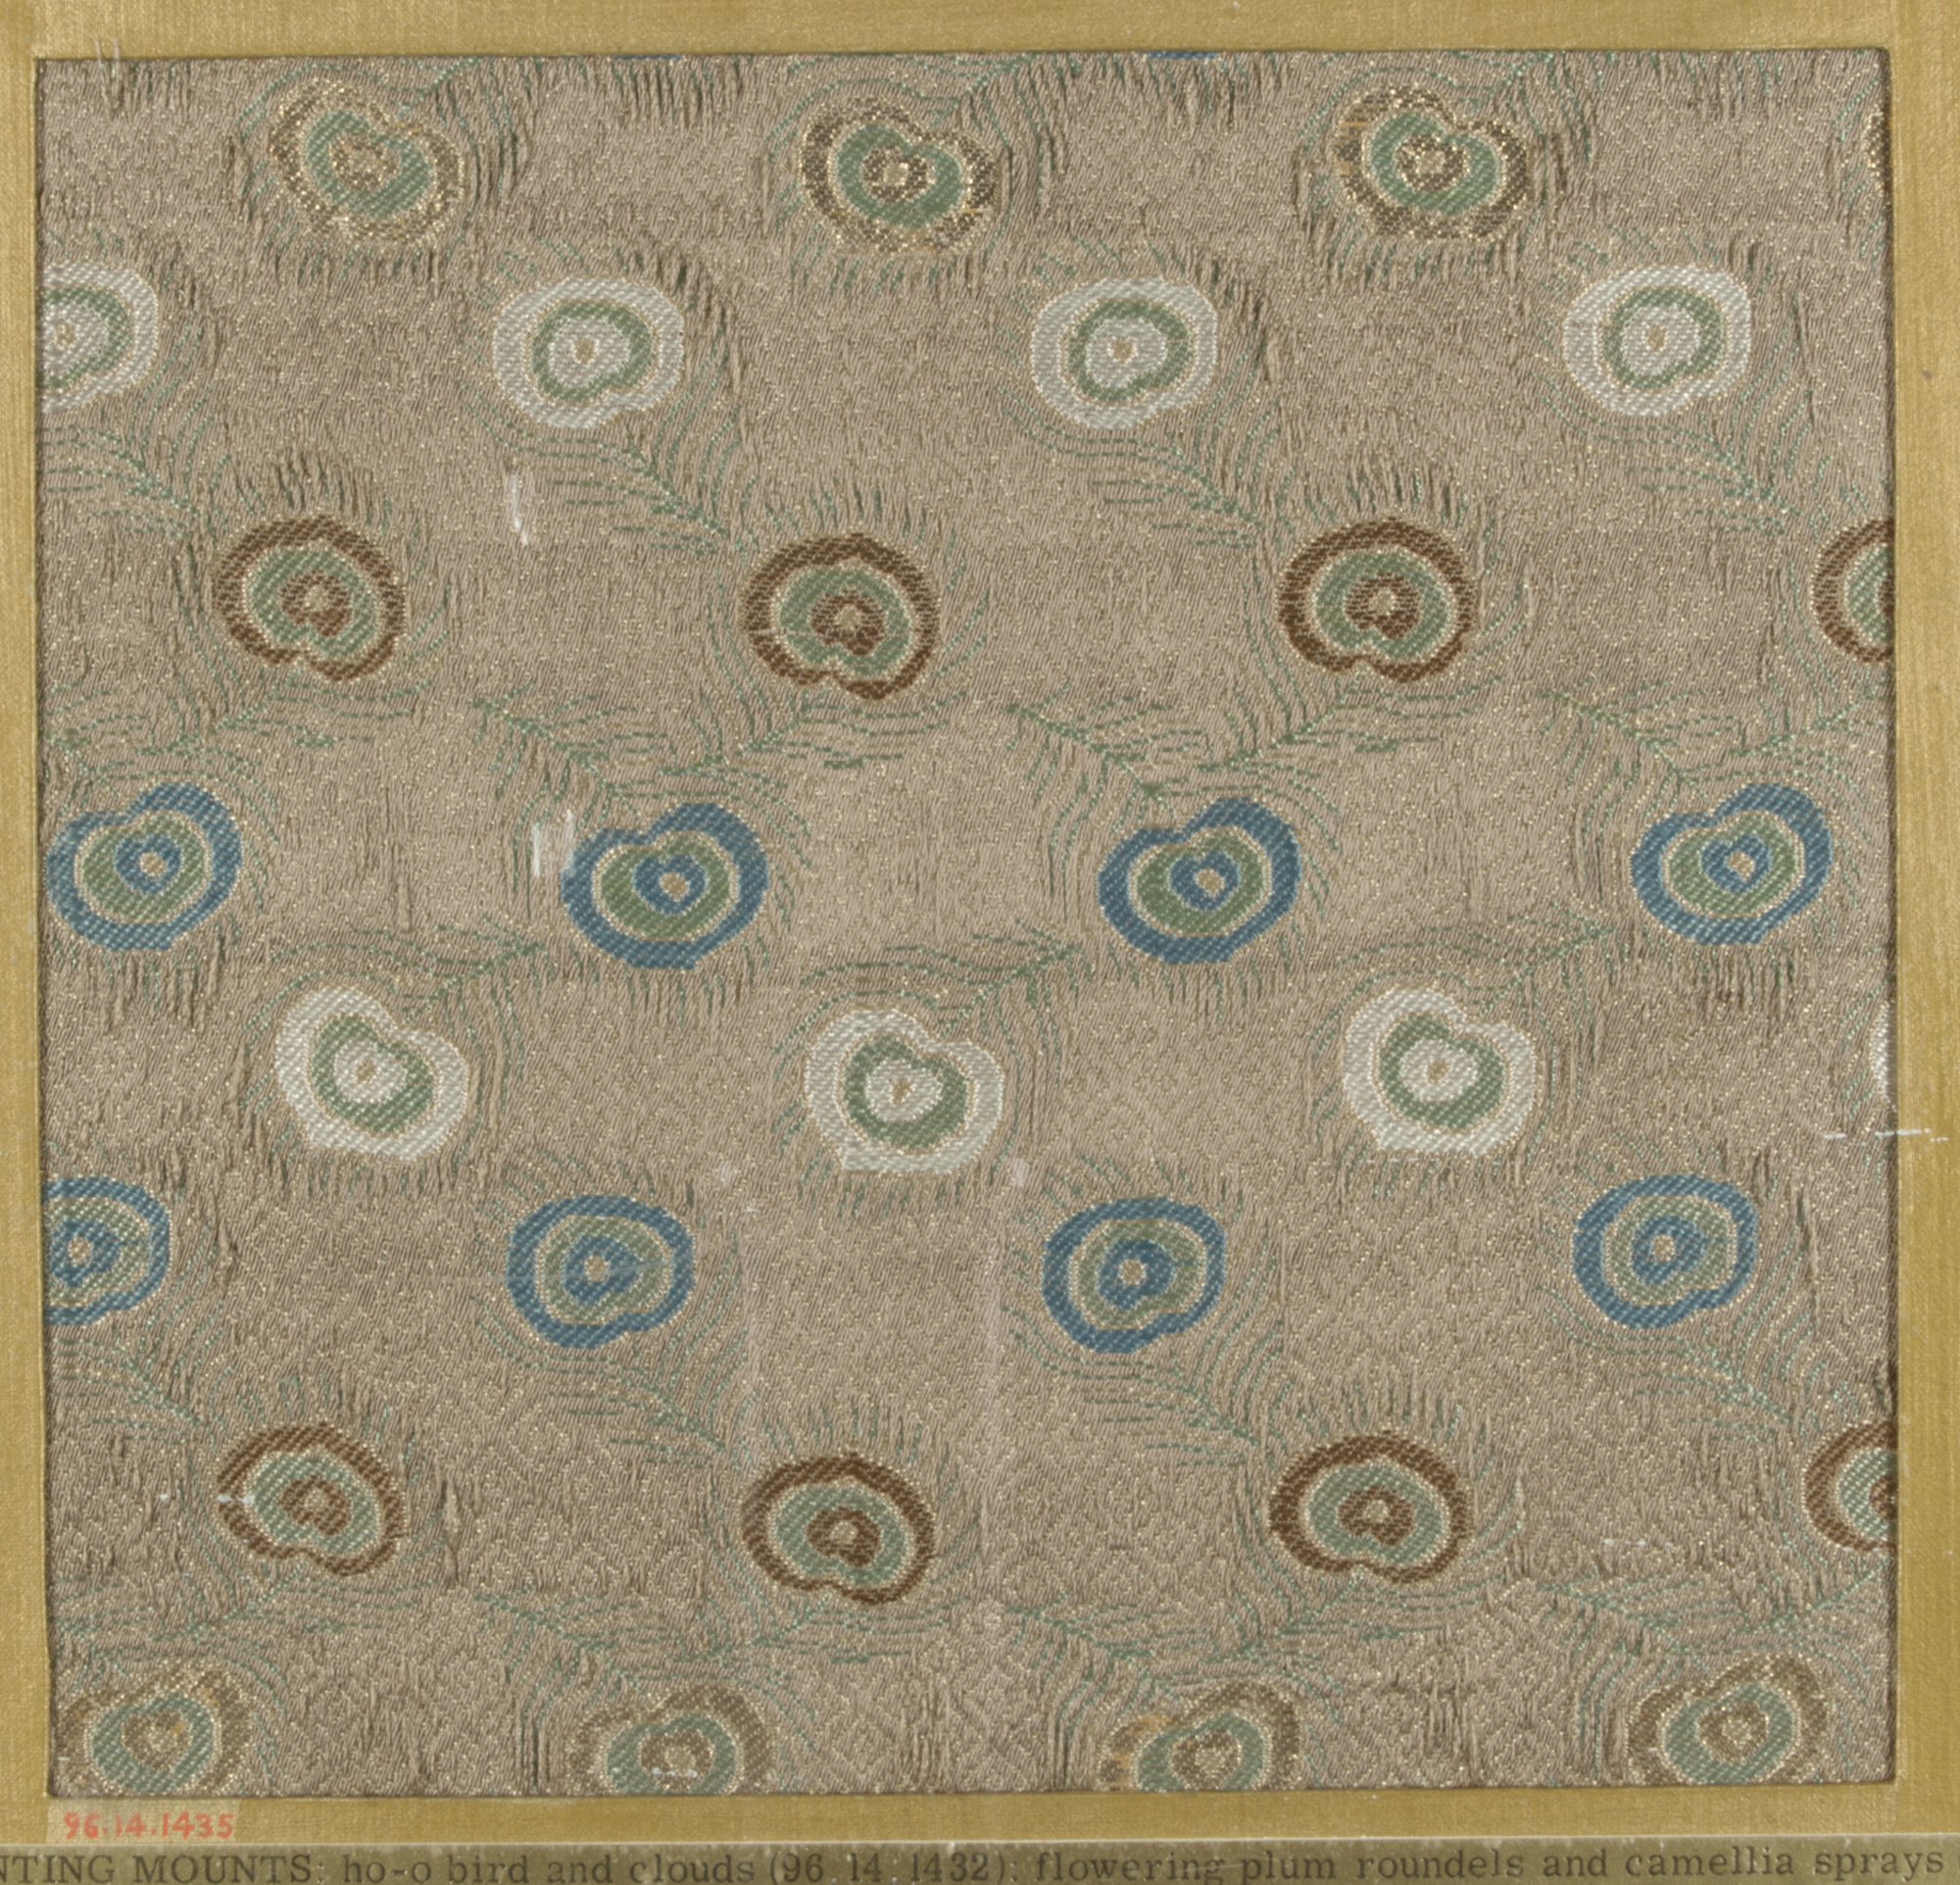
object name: piece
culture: japanese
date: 1701-1900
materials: silk